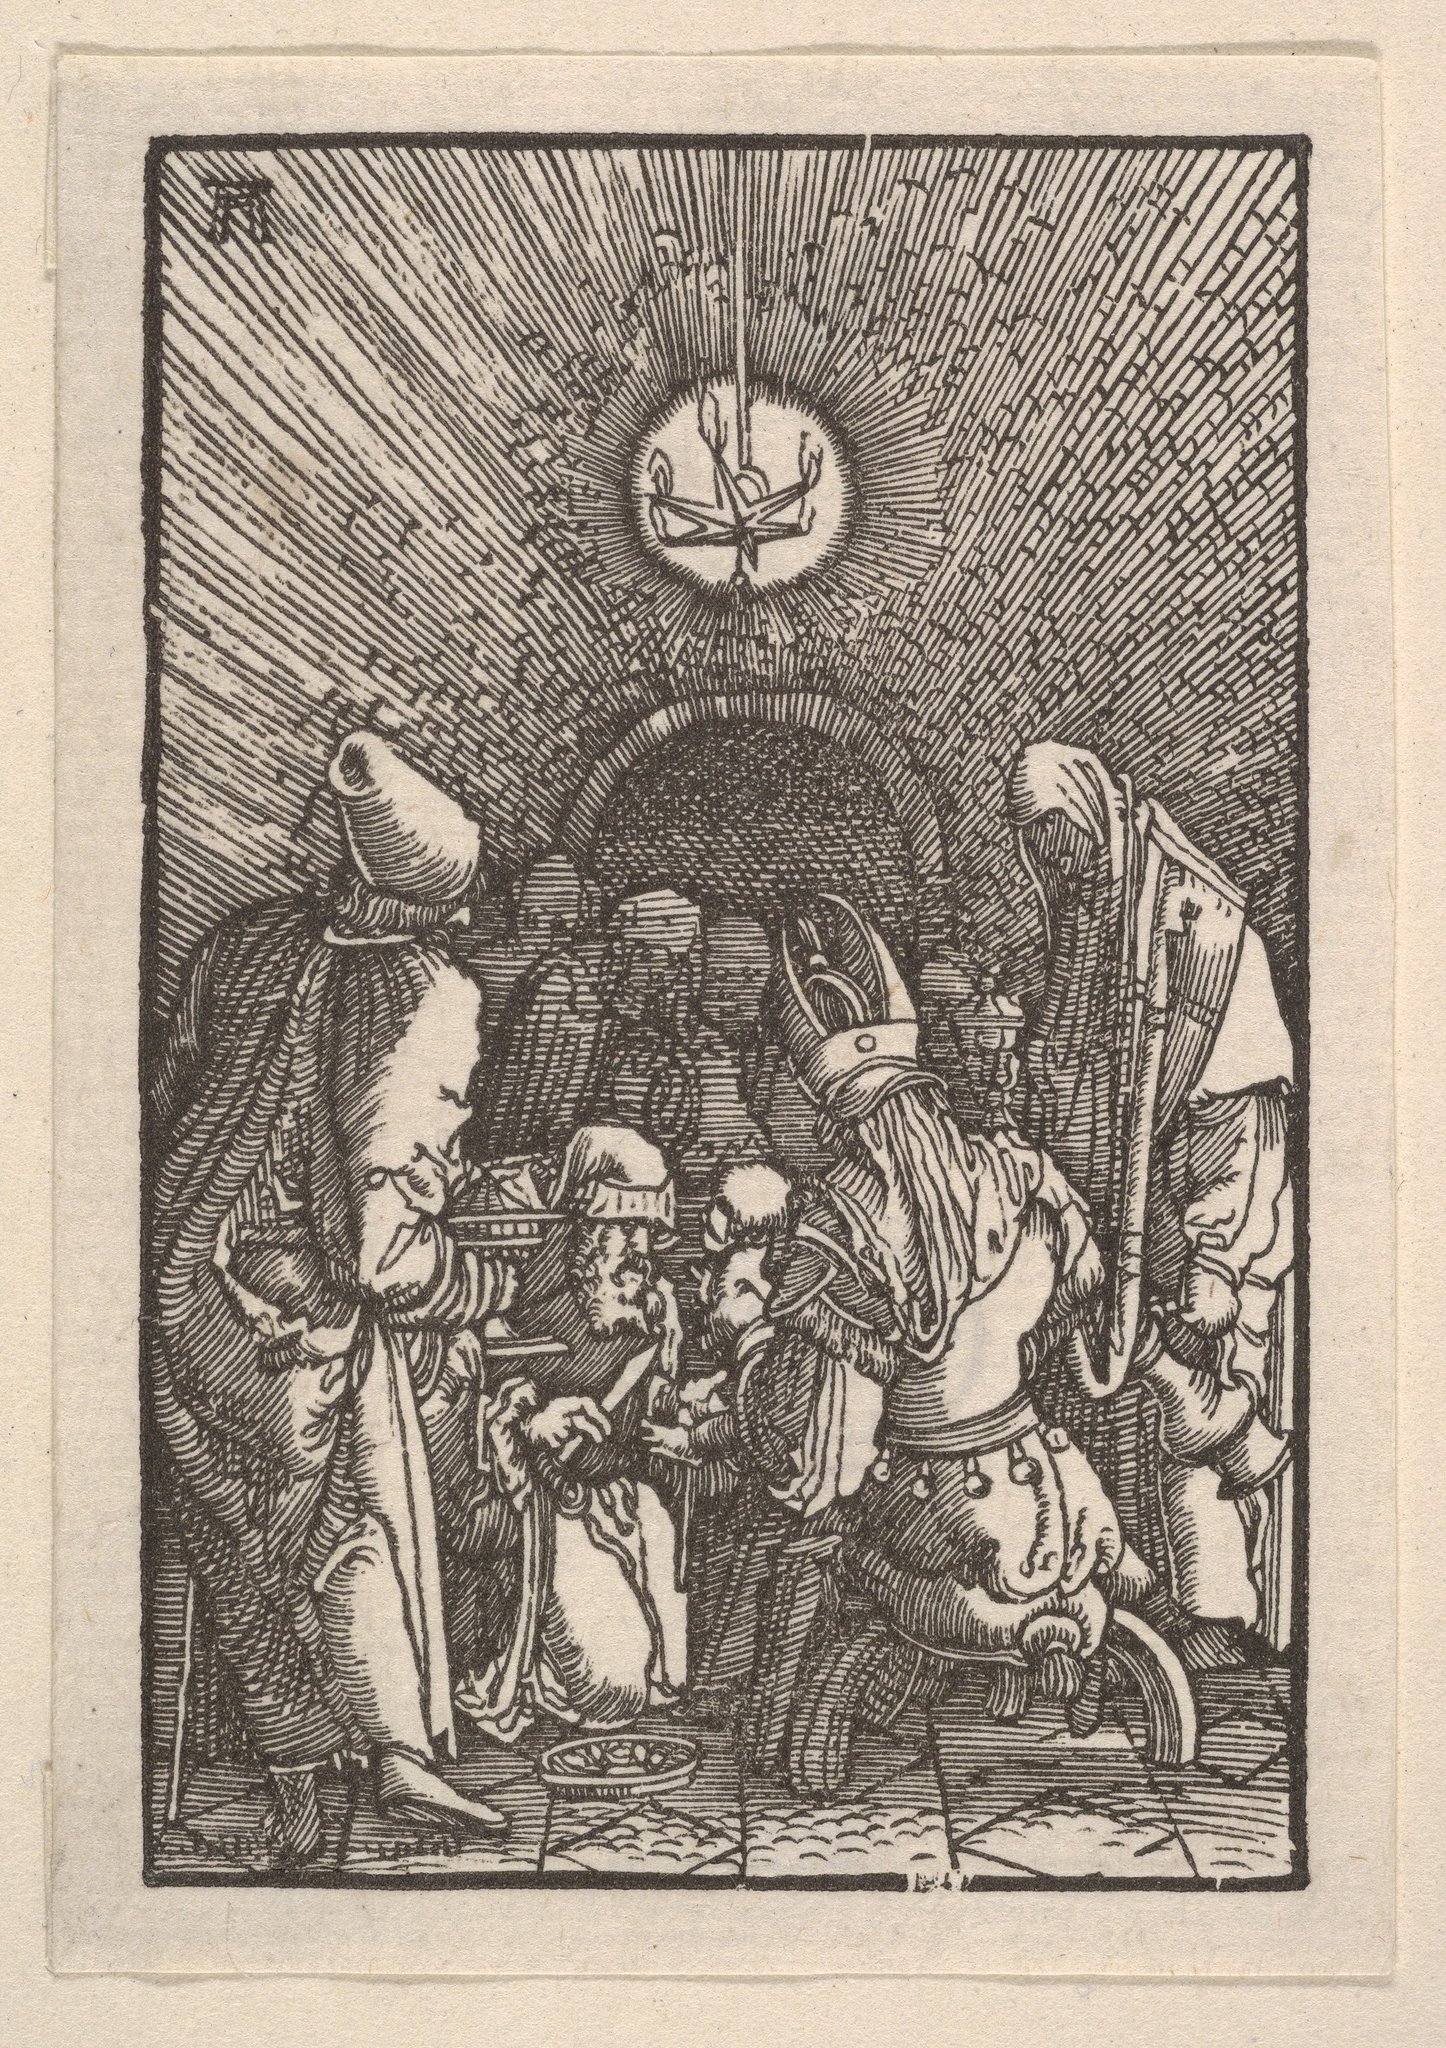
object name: print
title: Circumcision, from "The Fall and Salvation of Mankind Through the Life and Passion of Christ"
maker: albrecht altdorfer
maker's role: artist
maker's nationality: german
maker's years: 1480-1538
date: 1500-1538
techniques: woodcut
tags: men,jesus,circumcision